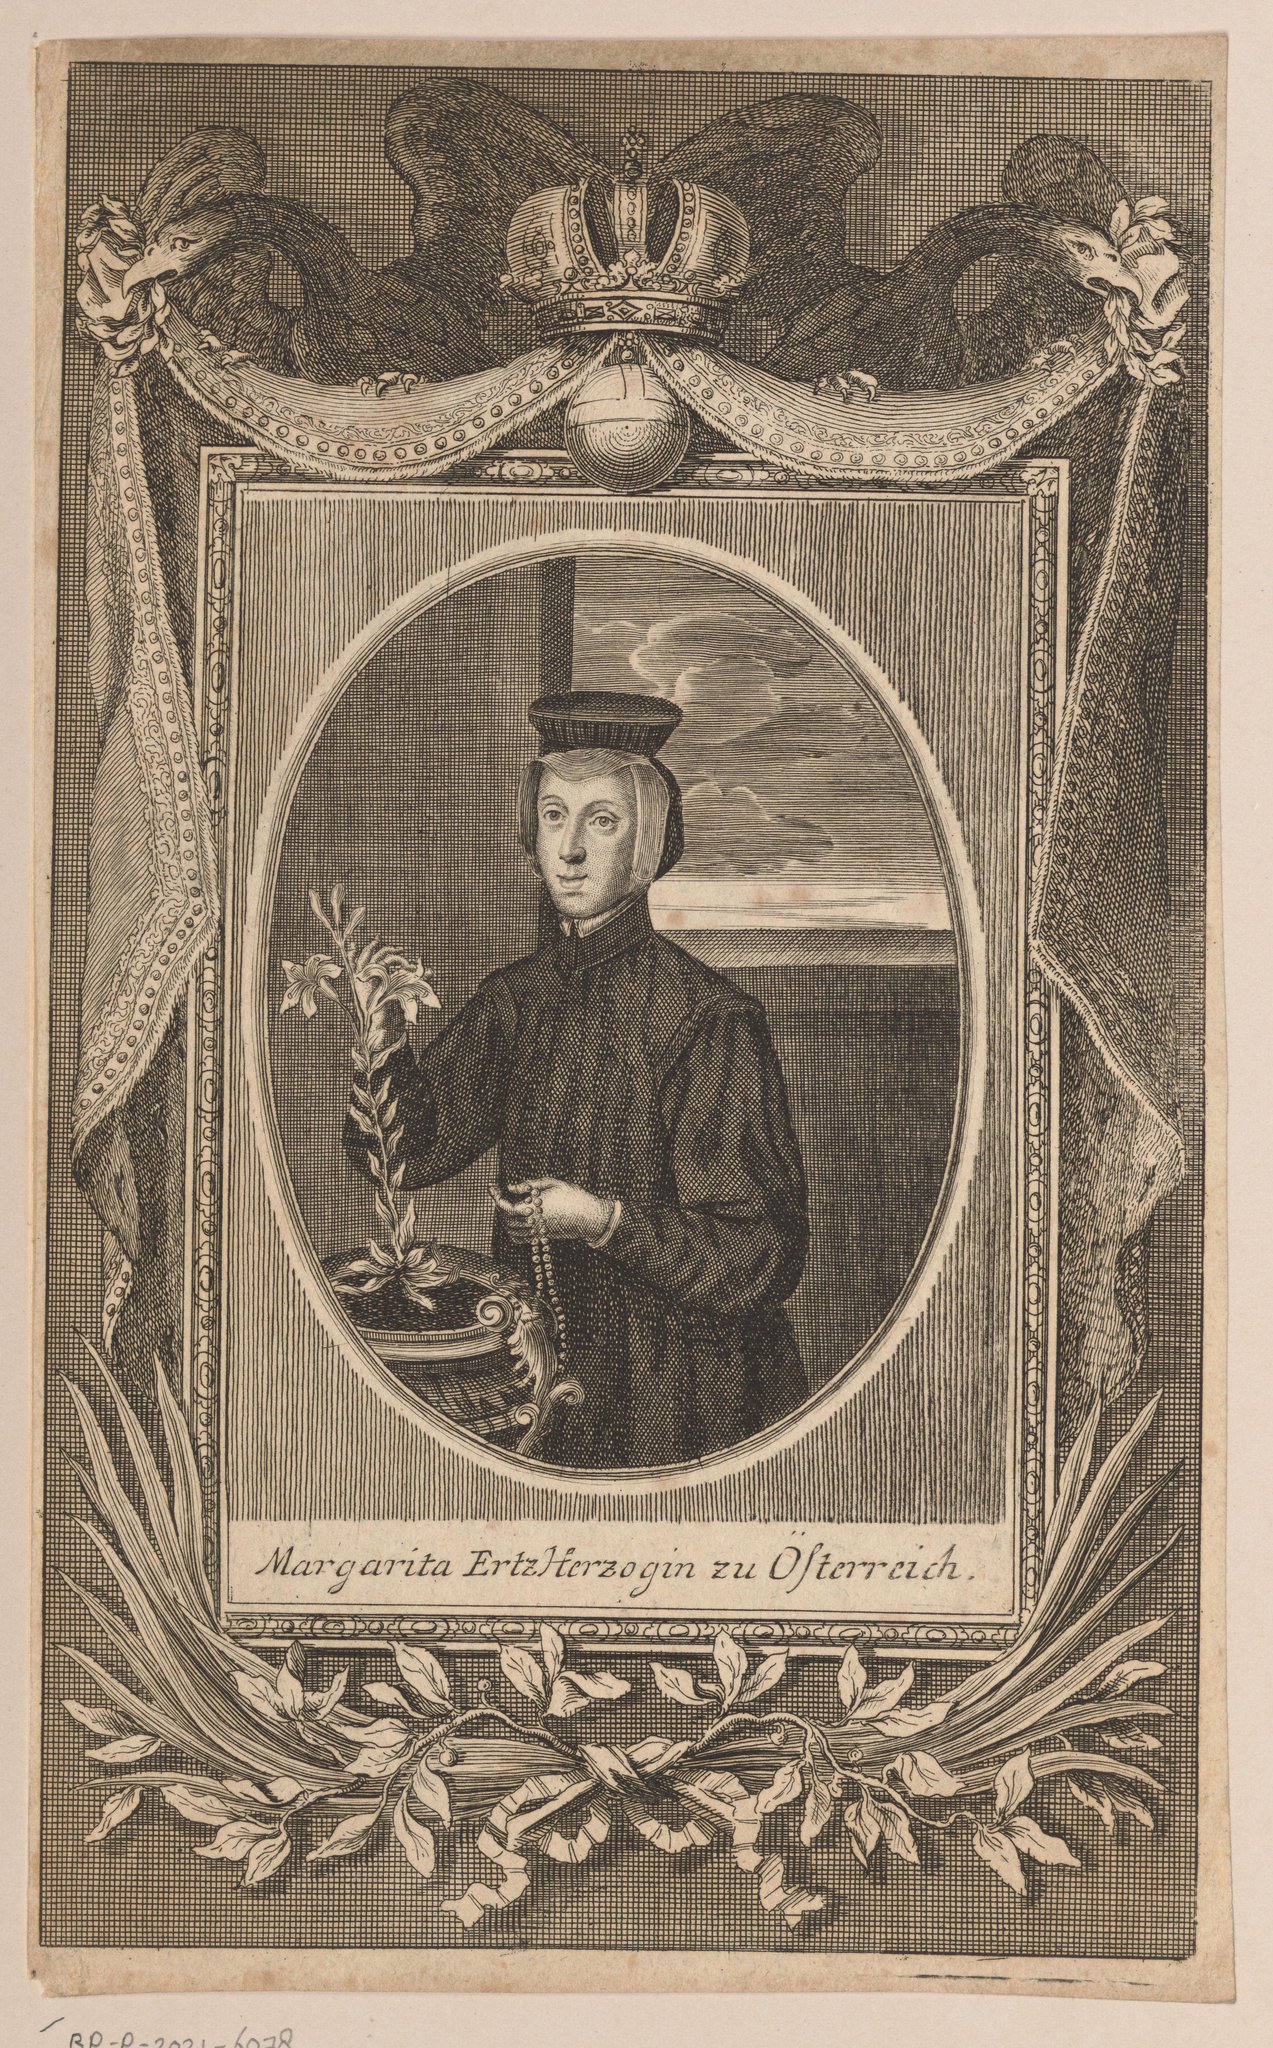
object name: book illustration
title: Portret van Margaretha, aartshertogin van Oostenrijk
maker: johann friedrich rosbach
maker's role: print maker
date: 1721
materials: paper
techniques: engraving, etching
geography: germany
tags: crown (symbol of sovereignty), predatory birds: eagle, orb (symbol of sovereignty; sphere with cross on top), historical persons - bb - woman, nun(s), flowers: lily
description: Prent waarschijnlijk uit: Khevenhüller, Franz Christoph. Conterfet Kupfferstich (...). Leipzig: Moritz Georg Weidmann, 1721, dl. 1. De prent is ook met een andere omlijsting gedrukt in dit werk.